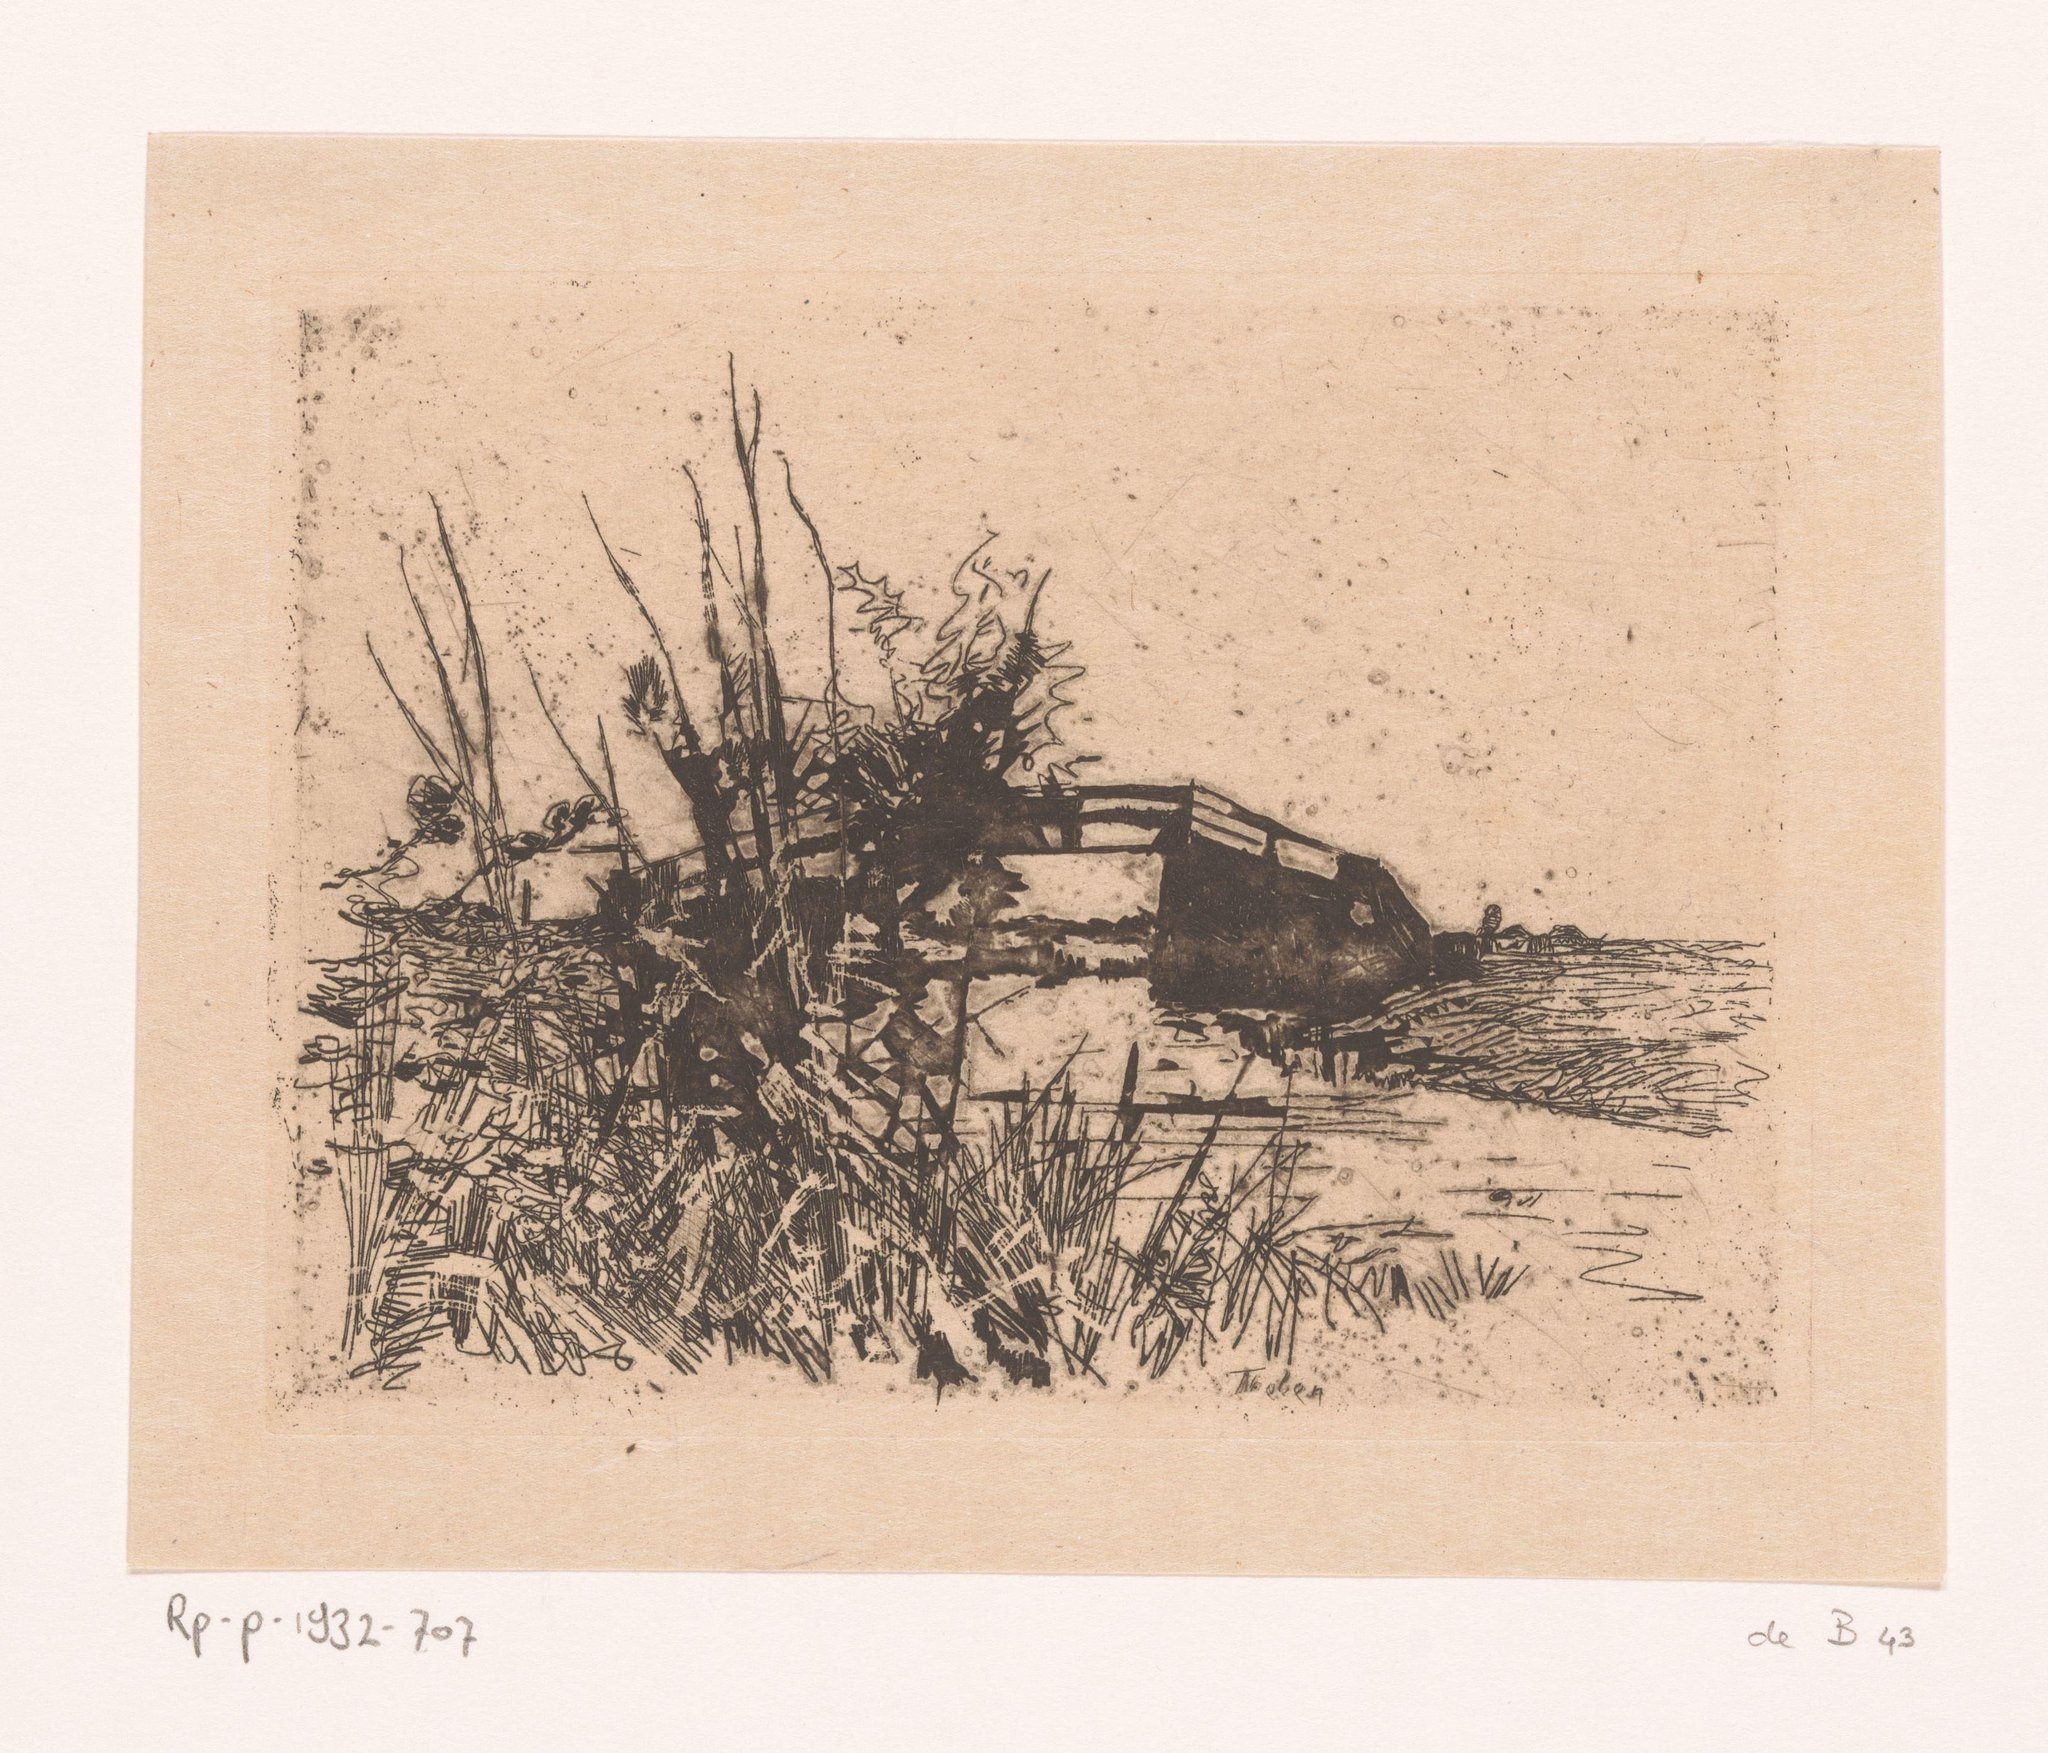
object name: print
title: Hoge brug, Giethoorn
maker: willem bastiaan tholen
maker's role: draughtsman, painter, print maker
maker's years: 1860-1931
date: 1870-1931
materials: paper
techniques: etching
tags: bridge, small canal, ditch